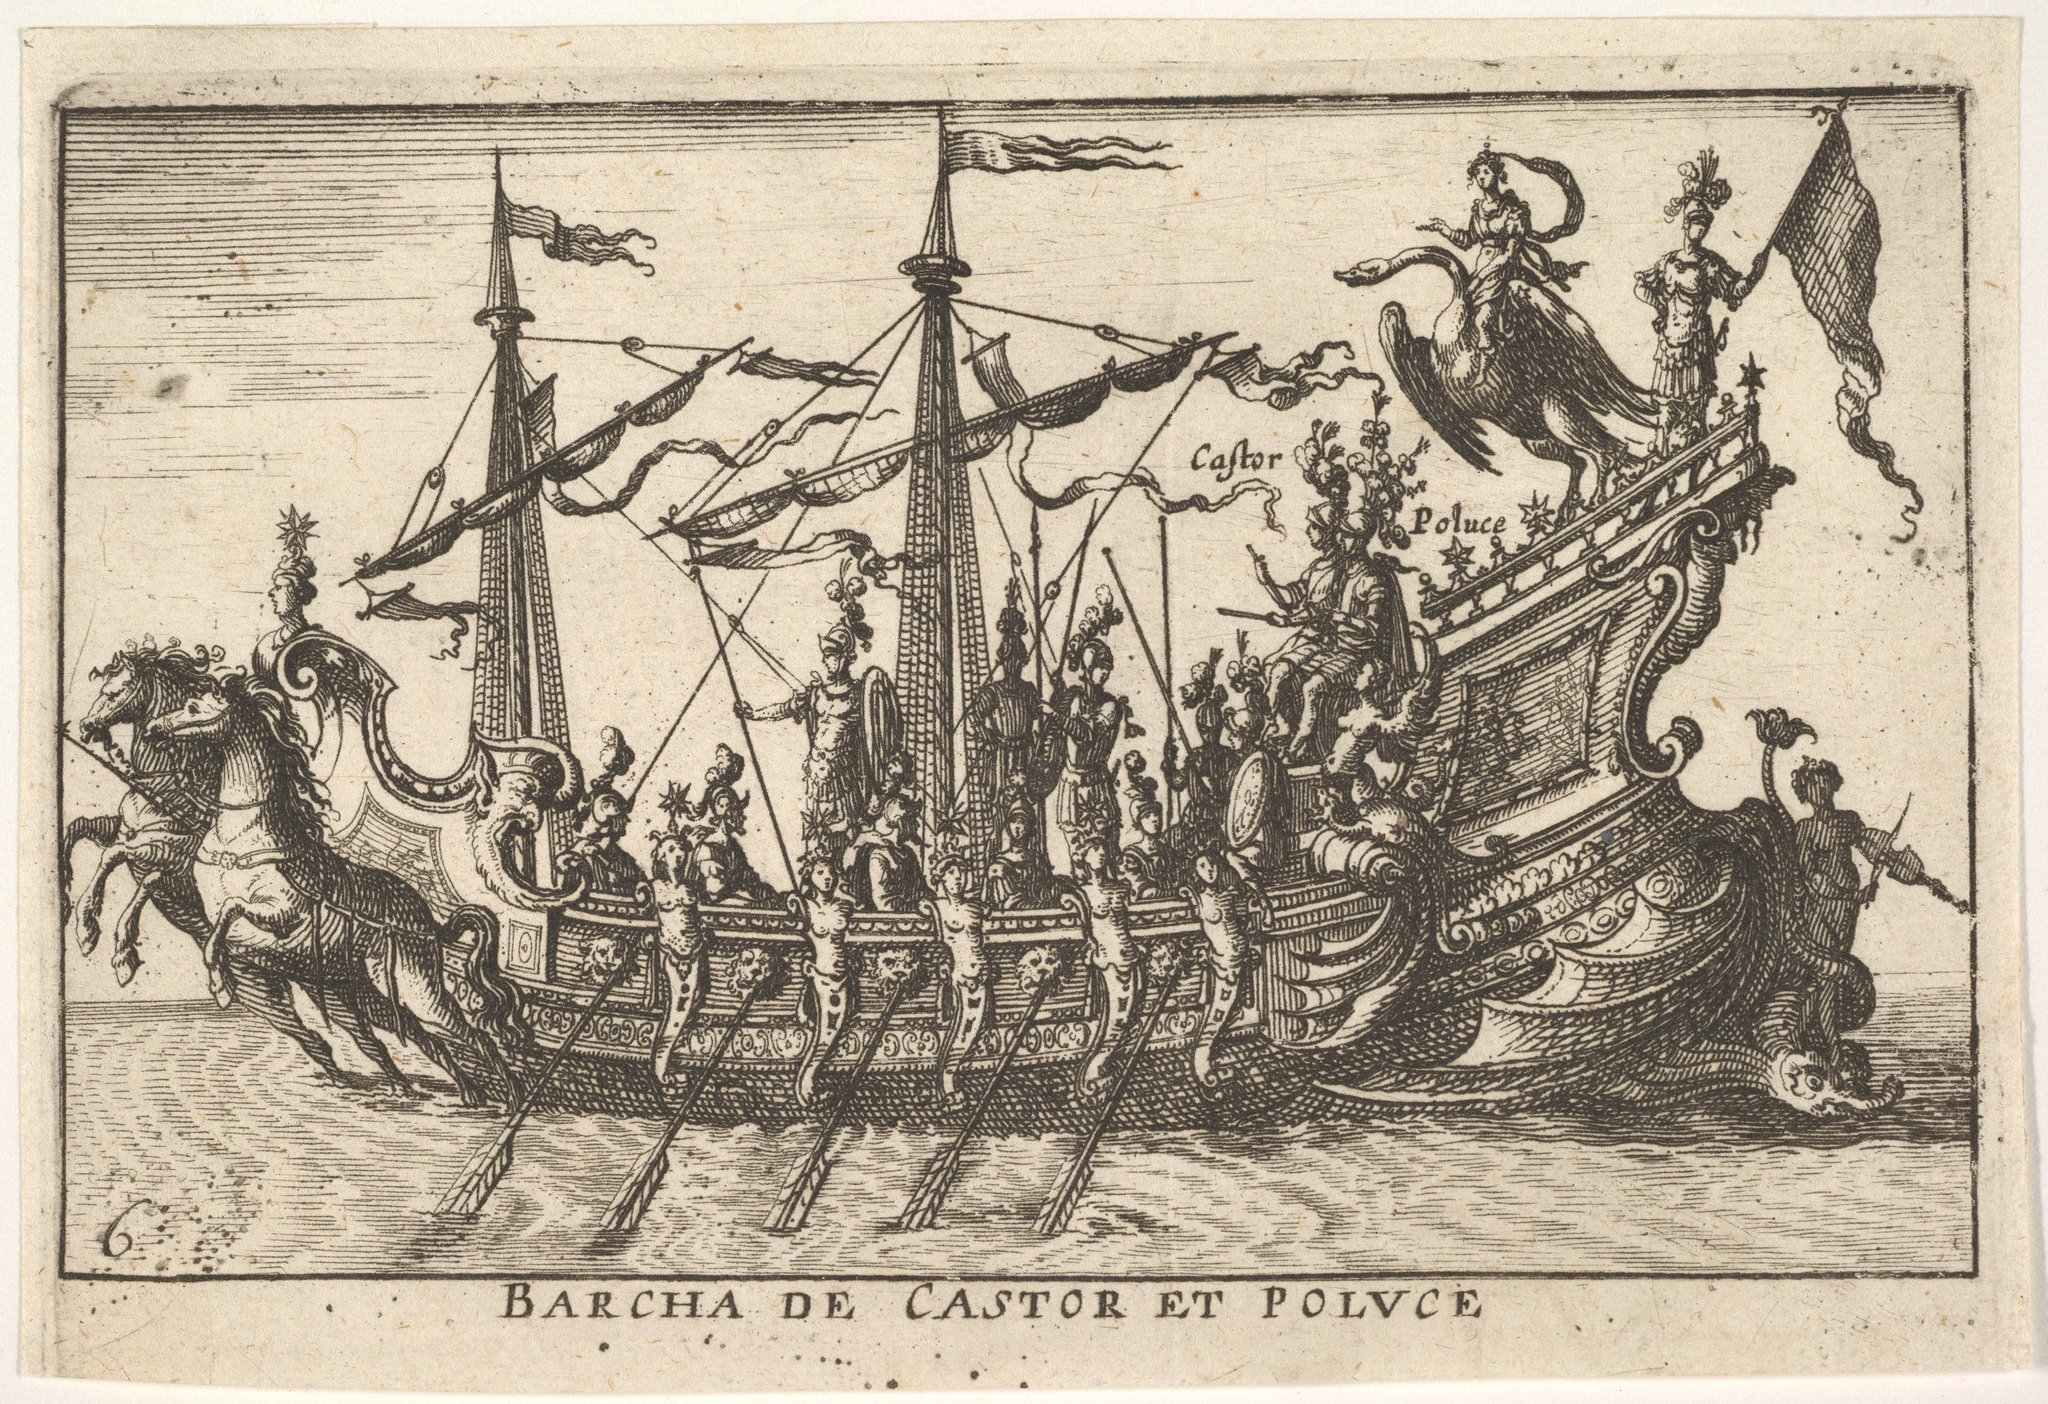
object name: print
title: Plate 6: Ship of Castor and Pollux (Barcha de Castor et Poluce), from "The magnificent pageant on the river Arno in Florence for the marriage of the Grand Duke" (Le Magnifique carousel fait sur le fleuve de l'Arne a Florence, pour le mariage du Grand Duc)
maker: Anonymous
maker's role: artist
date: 1664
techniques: etching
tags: soldiers,horses